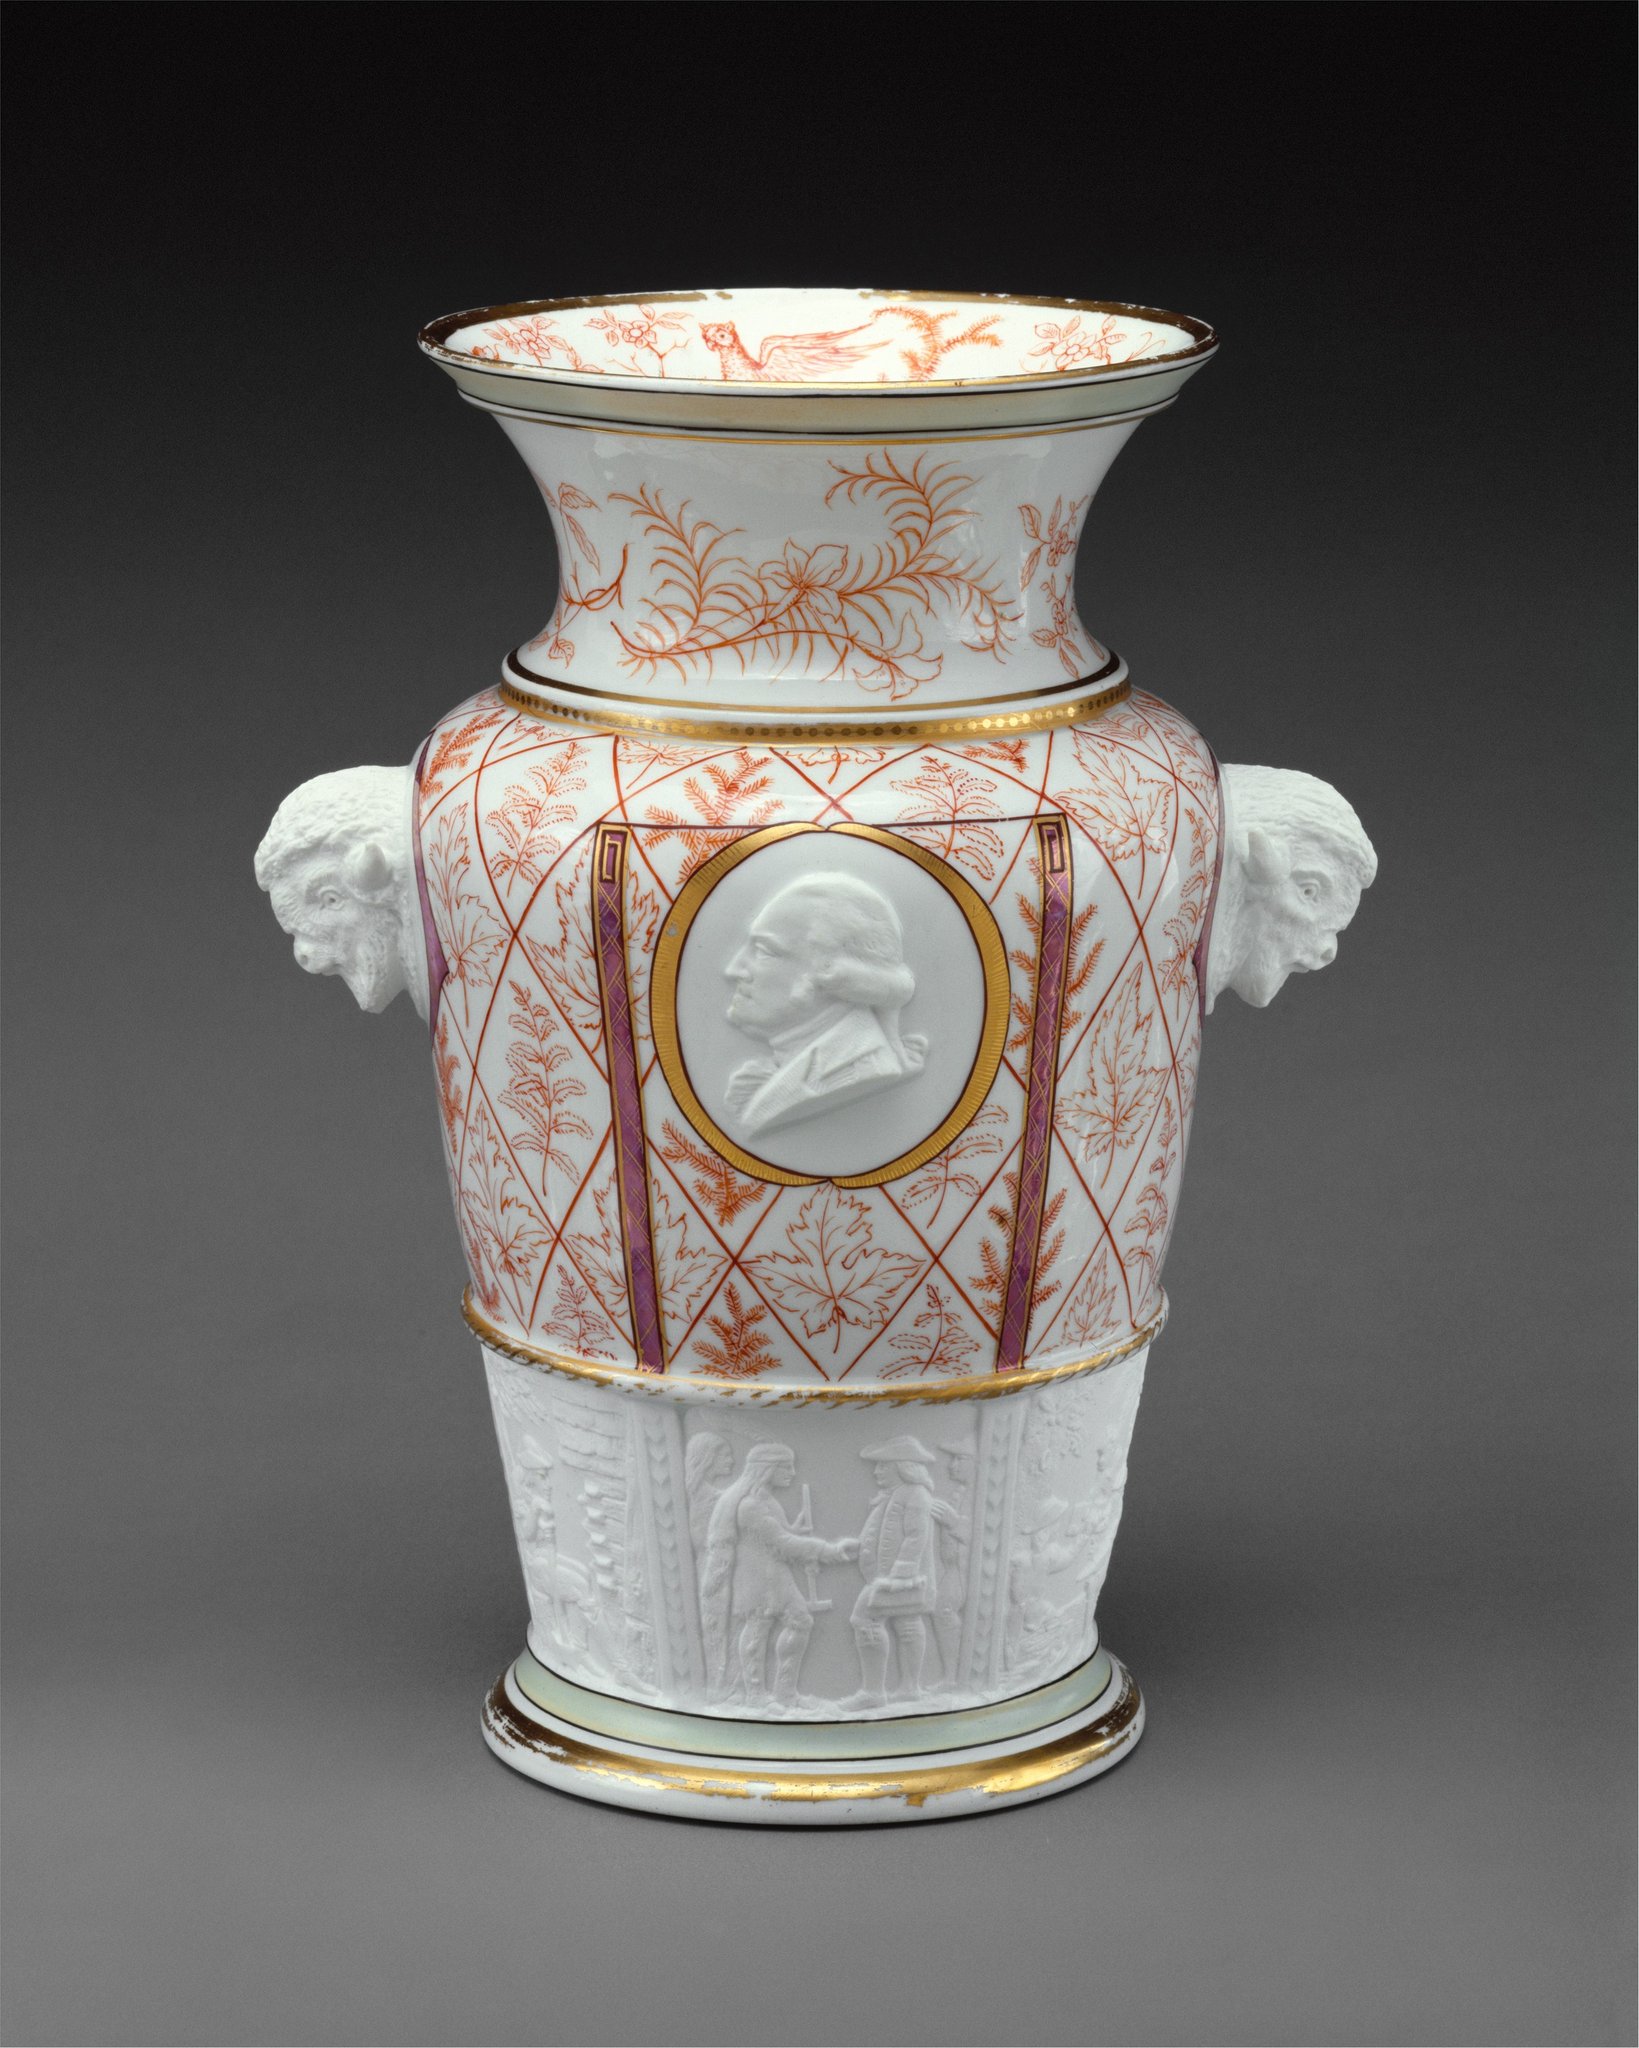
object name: vase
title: Century Vase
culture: american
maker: karl l. h. müller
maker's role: designer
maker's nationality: american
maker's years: 1820-1887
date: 1876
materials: porcelain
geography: united states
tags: animals,george washington,men